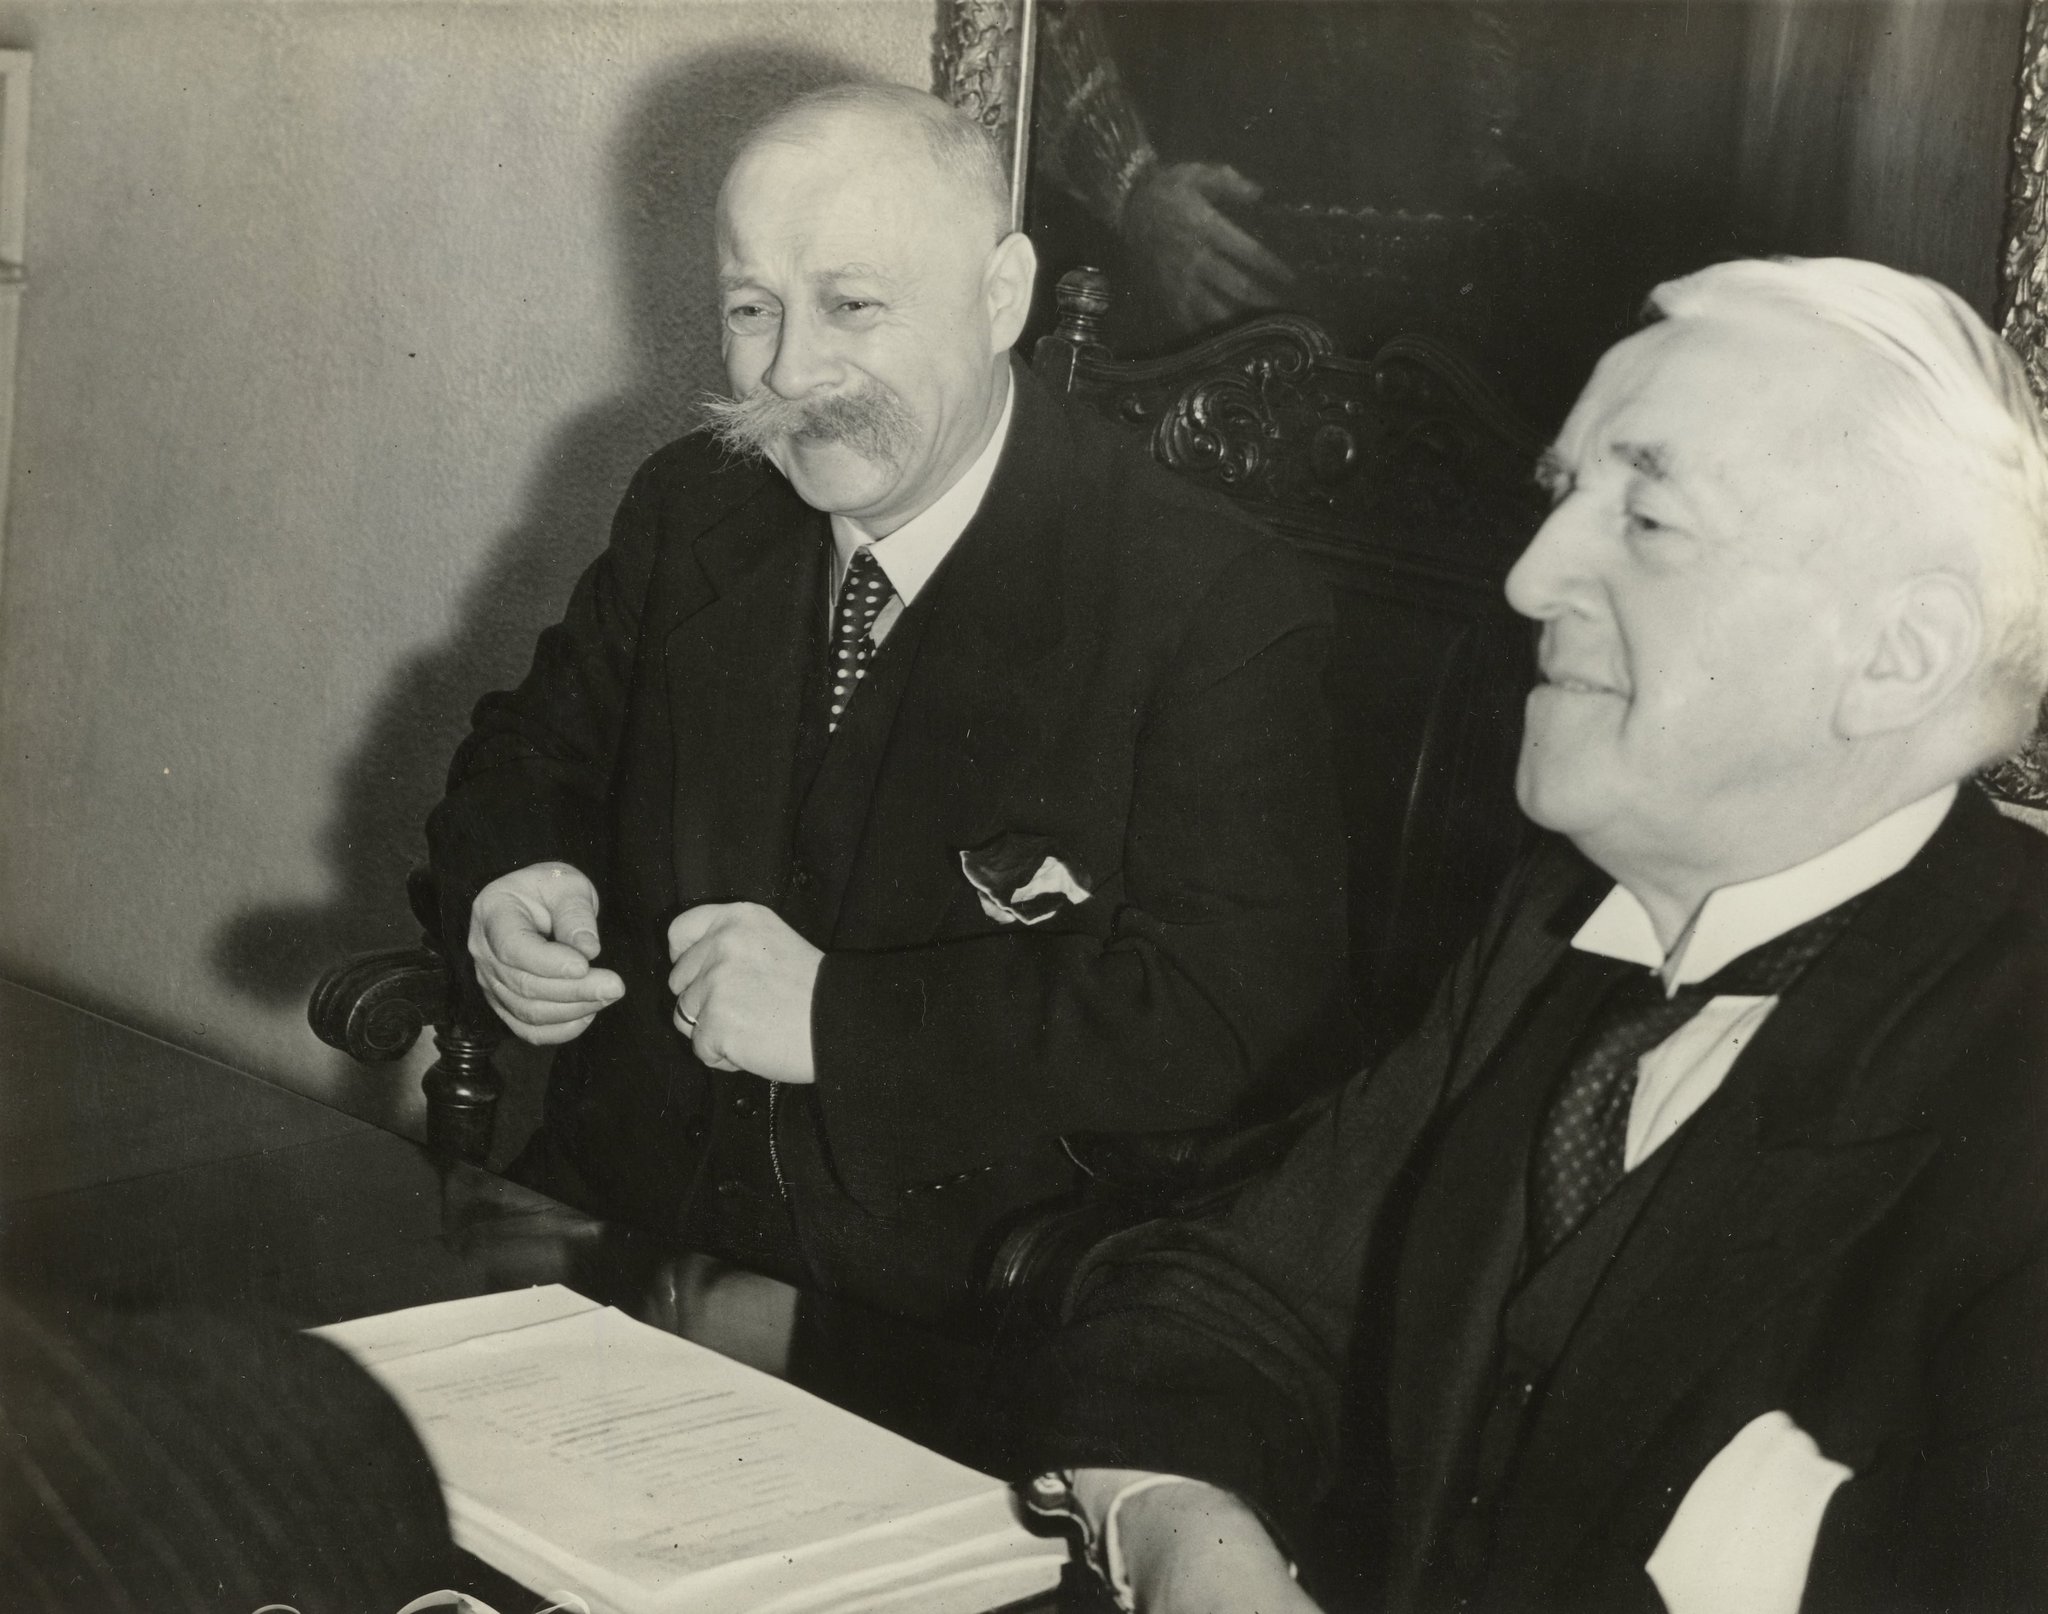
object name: photograph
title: Minister-president Gerbrandy en minister Bolkestein tijdens de ministerraad in het Stratton House in Londen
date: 1940-1945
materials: photographic support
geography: london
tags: amsterdam, pieter sjoerds gerbrandy, london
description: Minister-president Pieter Sjoerd Gerbrandy (1885-1961) en minister van onderwijs, kunsten en wetenschappen Gerrit Bolkestein (1871-1956) tijdens de ministerraad in het Stratton House in Londen. Bolkestein (rechts) was één van de weinigen die gedurende de gehele Londense periode minister is gebleven. In 1943 riep hij vanuit Londen de studenten op om de Duitse loyaliteitsverklaring niet te tekenen. Foto afkomstig uit het archief van Cor Visser